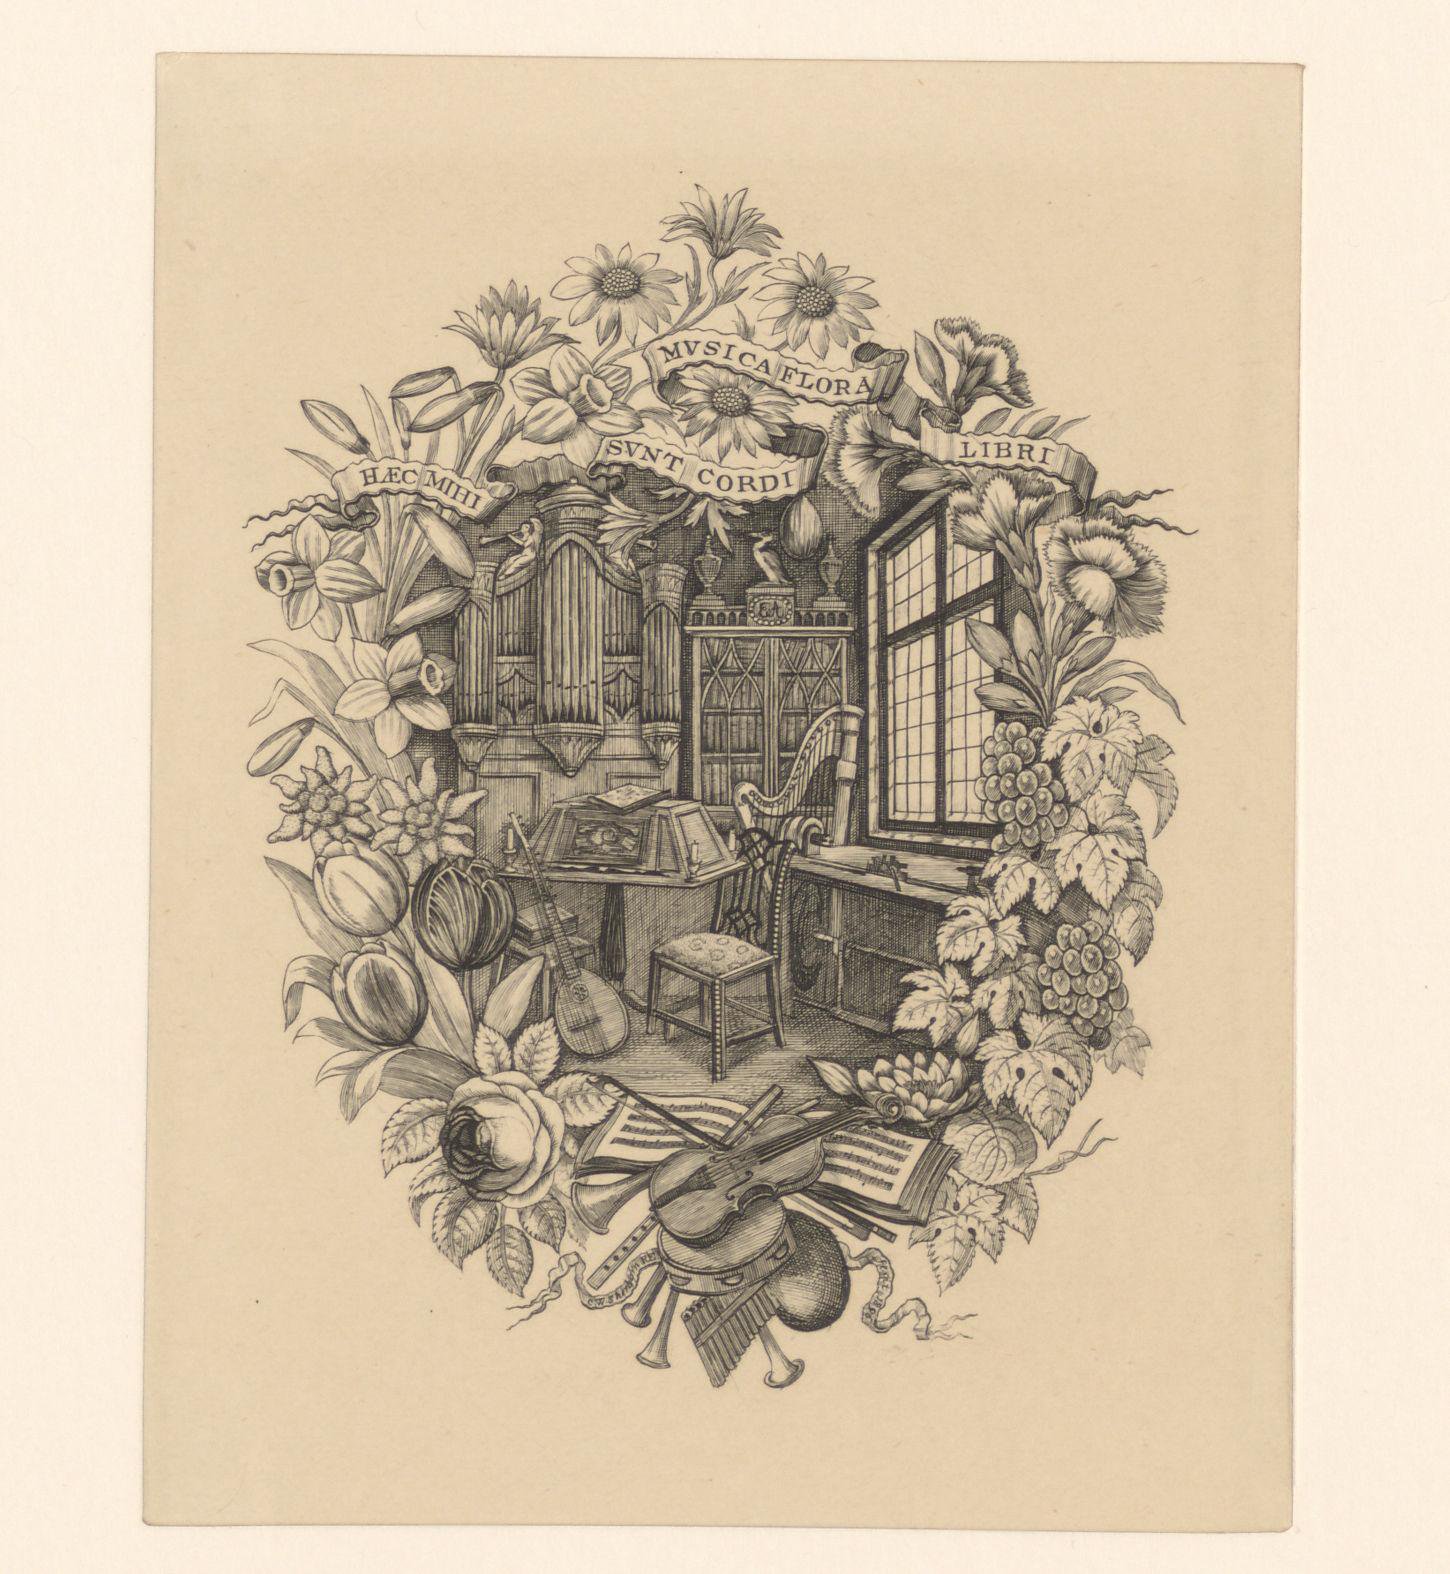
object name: bookplate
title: Ex libris van van onbekend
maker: charles william sherborn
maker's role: print maker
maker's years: 1831-1912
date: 1896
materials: paper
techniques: engraving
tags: flowers, musical instruments; group of musical instruments, foliage ~ ornament, study; 'studiolo'; library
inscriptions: collector's mark: Lugt 2228